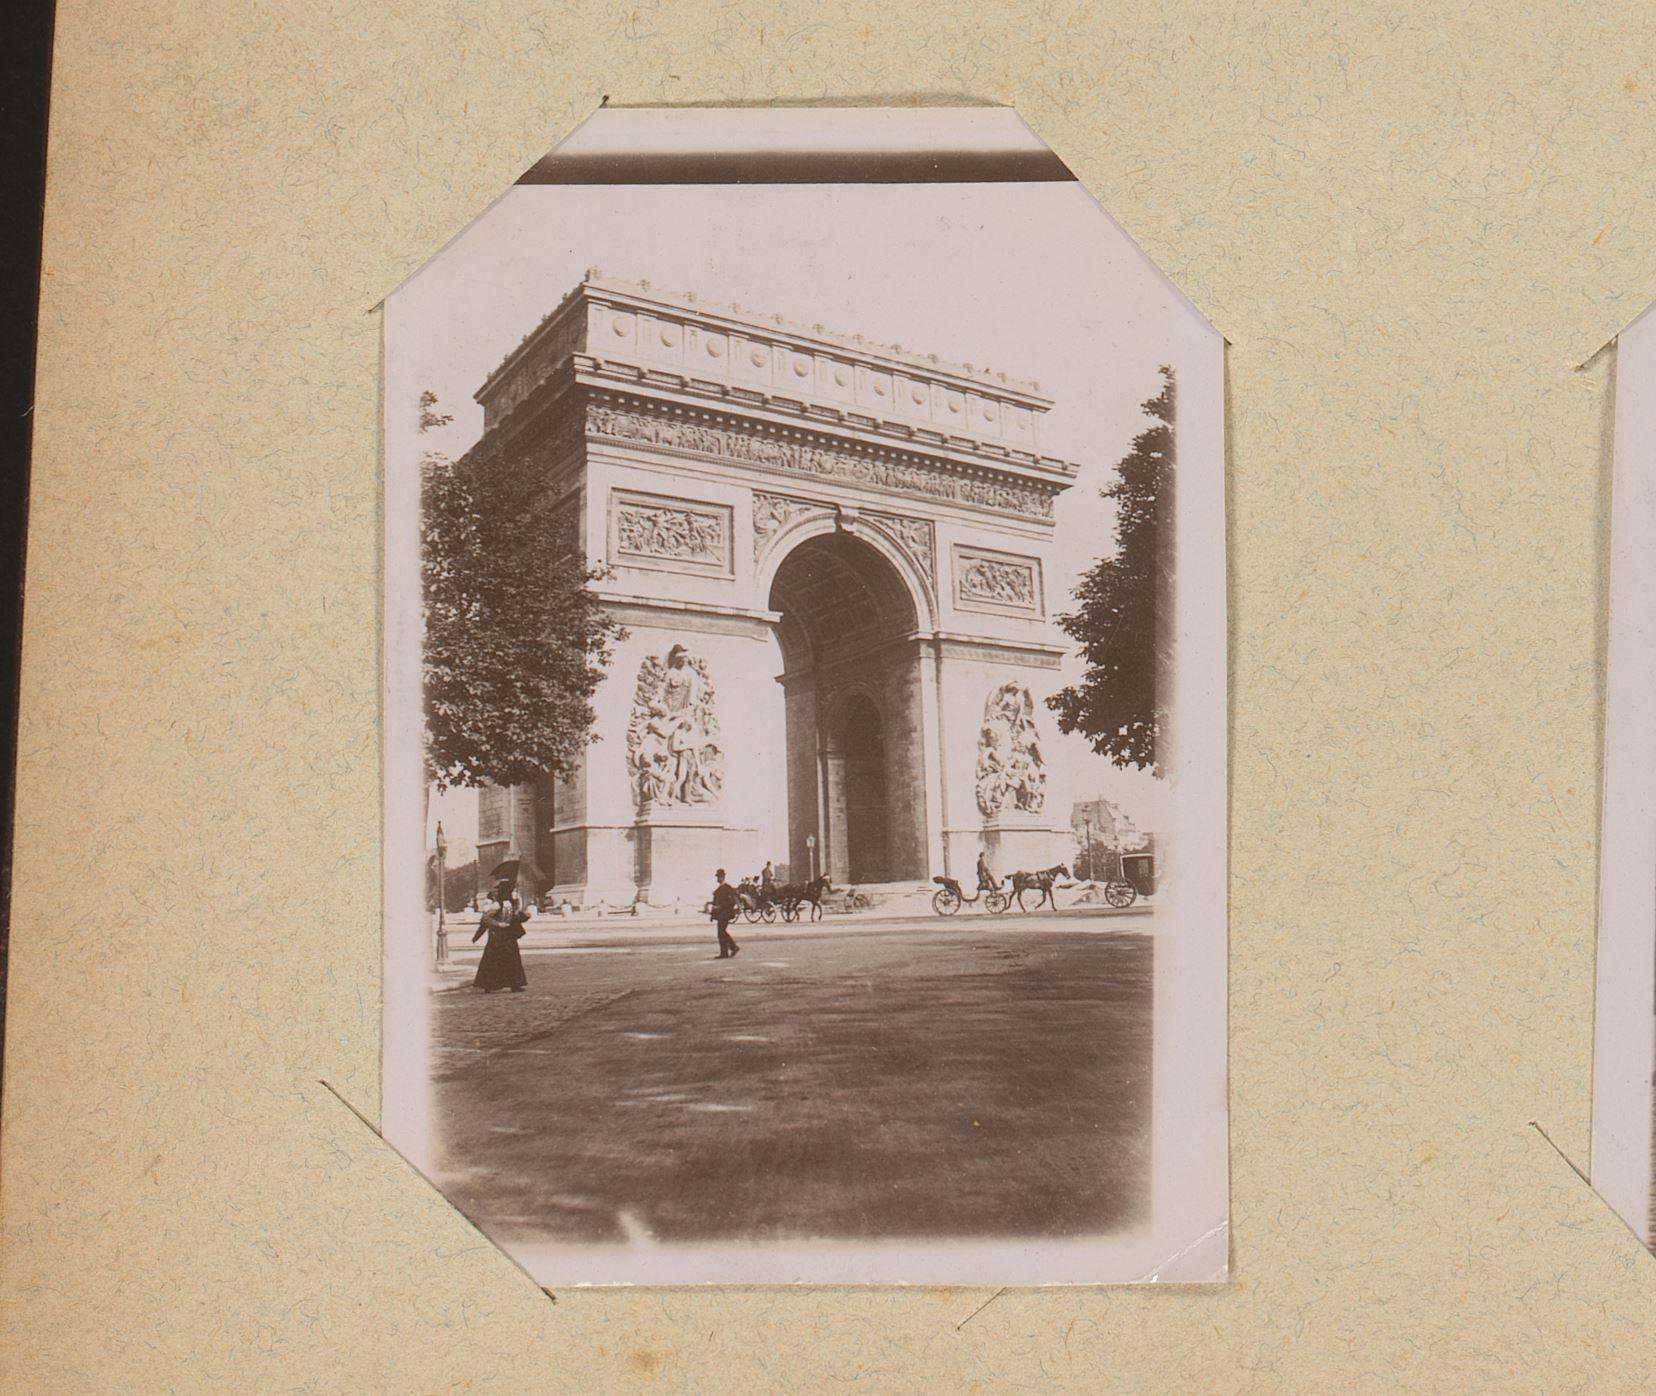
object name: photograph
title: Arc de Triomphe in Parijs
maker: Anonymous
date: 1895-1900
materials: paper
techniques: gelatin silver print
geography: paris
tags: triumphal arch